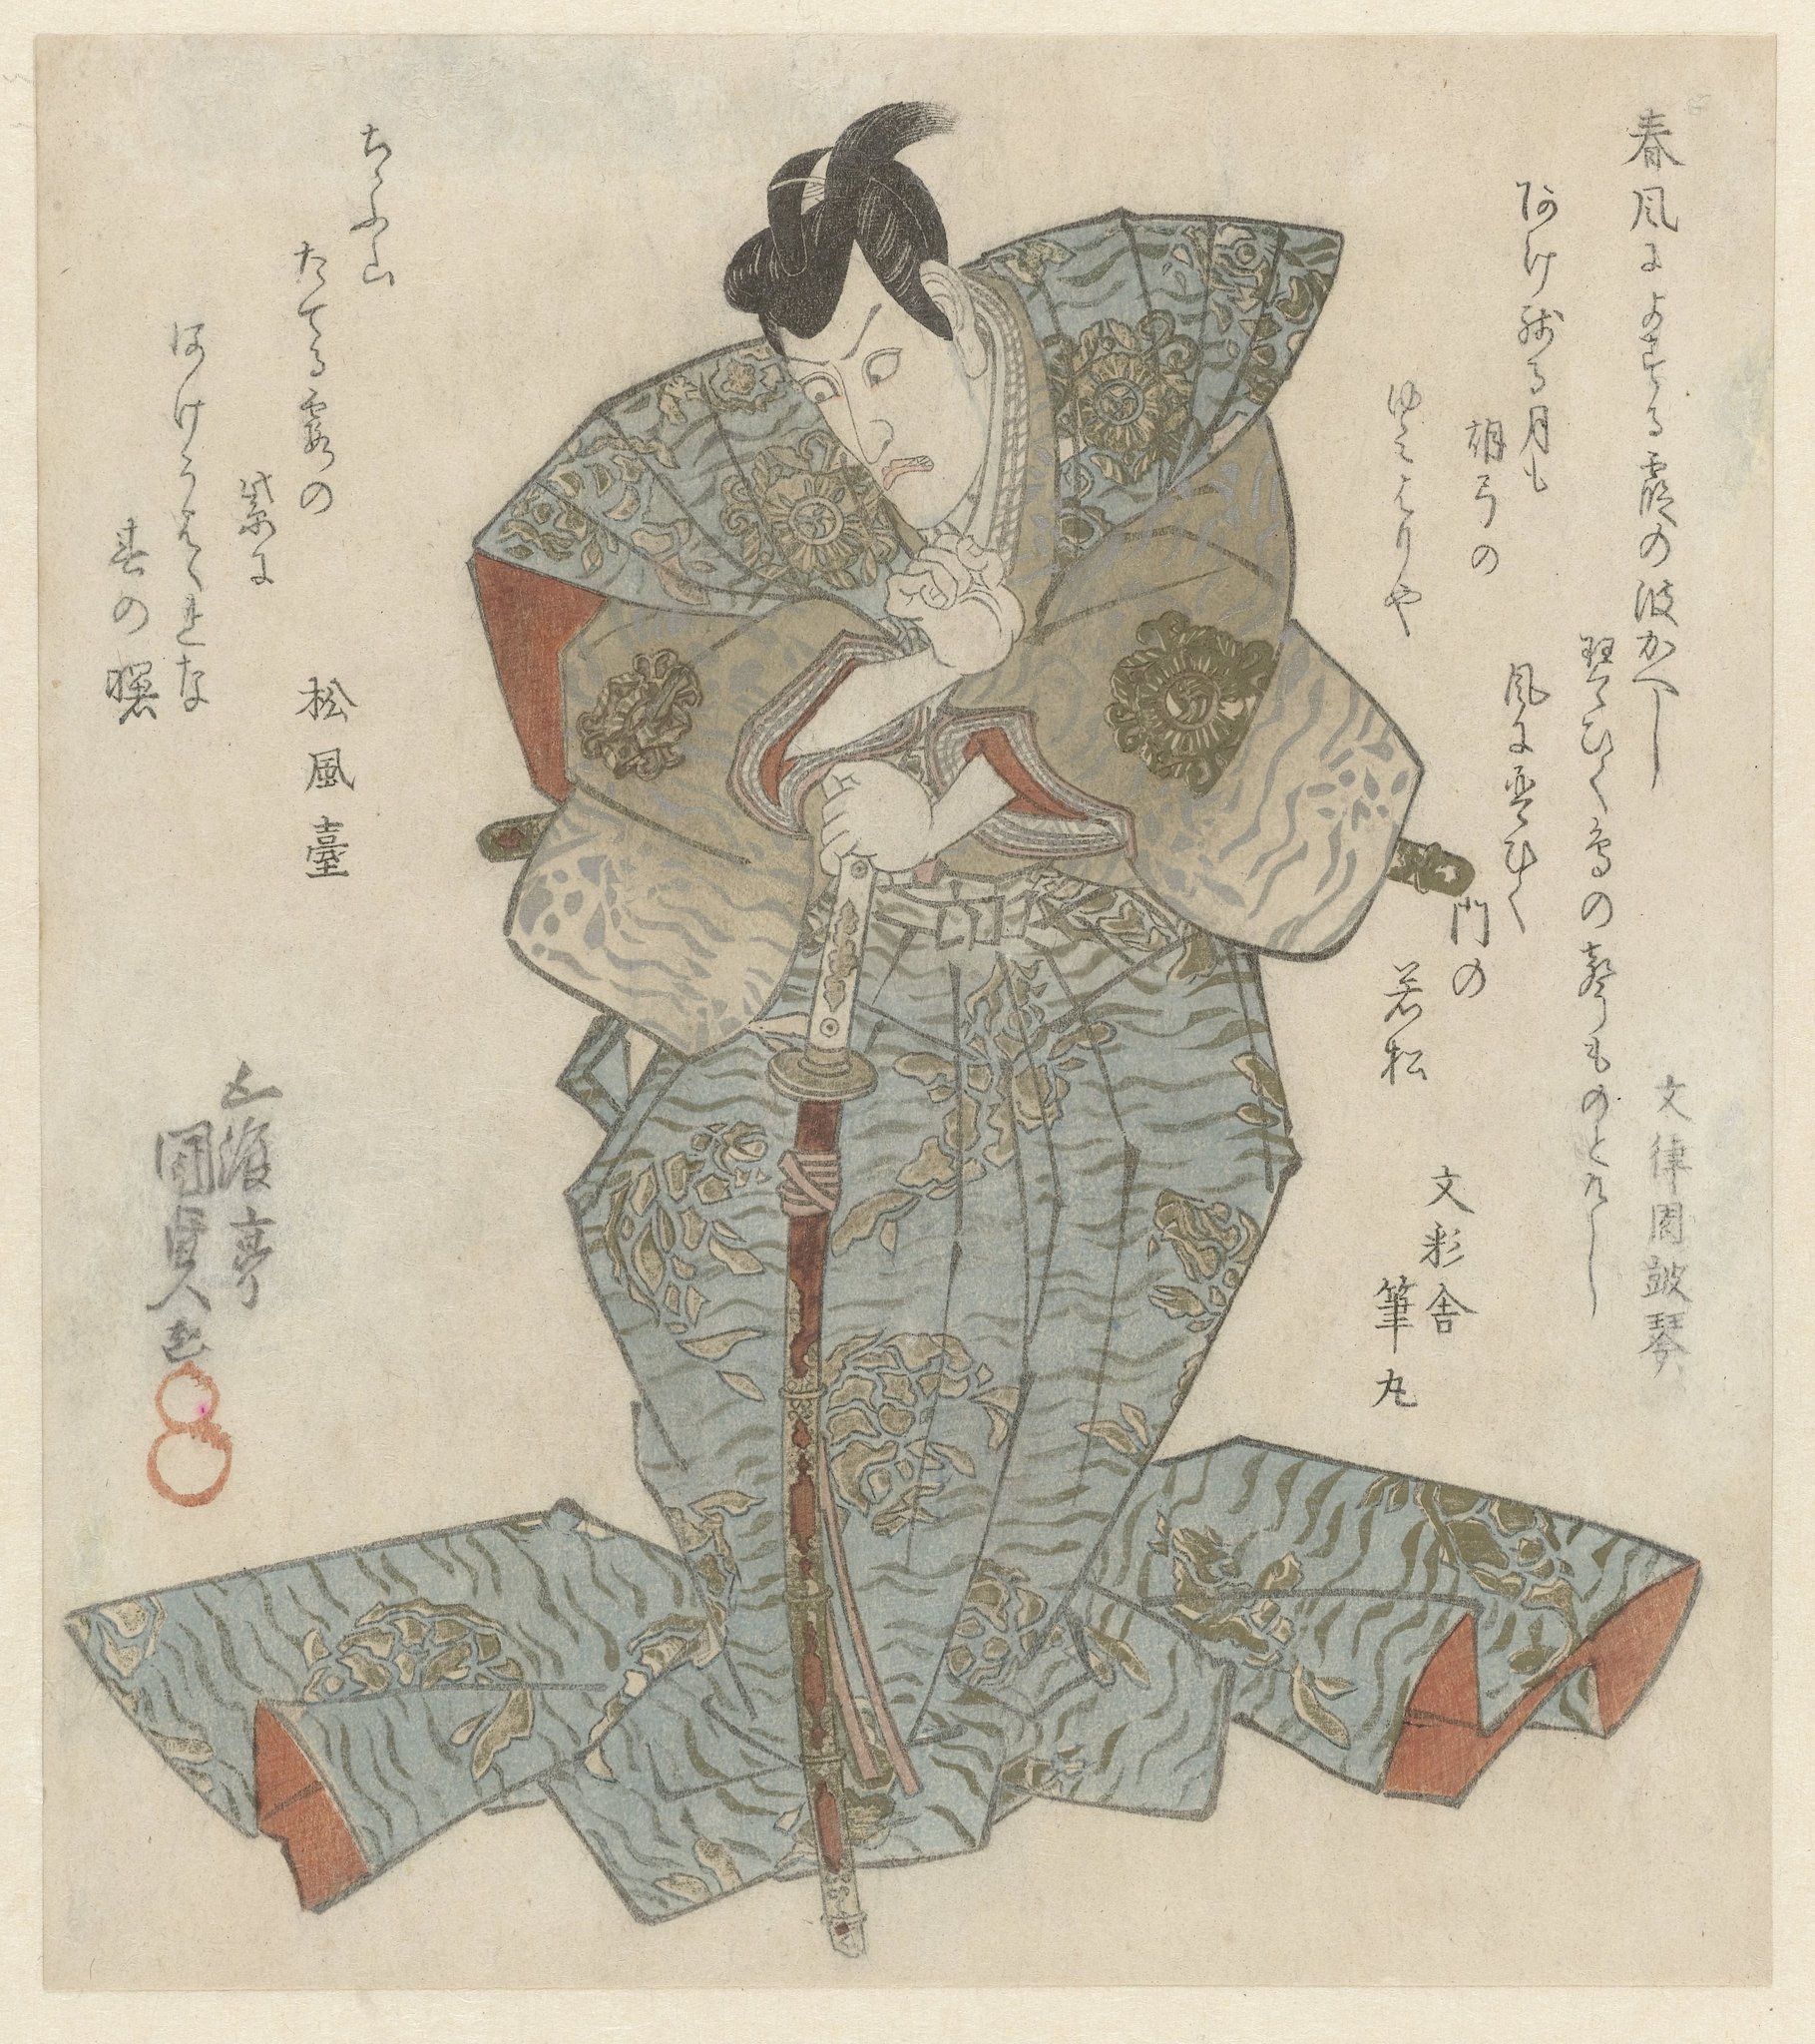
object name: print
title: Standing Lord in Blue Over-Kimono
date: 1825-1830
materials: paper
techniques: woodcut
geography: japan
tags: hacking and thrusting weapons: sword, portrait of actor, actress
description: Een surimono is een luxe uitgevoerde prent waarop beeld met één of meerdere gedichten gecombineerd is. Bij het drukken van een surimono werd vaak gebruik gemaakt van dikker papier, blinddruk en metaal pigmenten, zoals koper- en zilverpoeder. De prenten werden vaak in opdracht van dichters gemaakt en als exclusief geschenk aan vrienden en relaties gegeven.